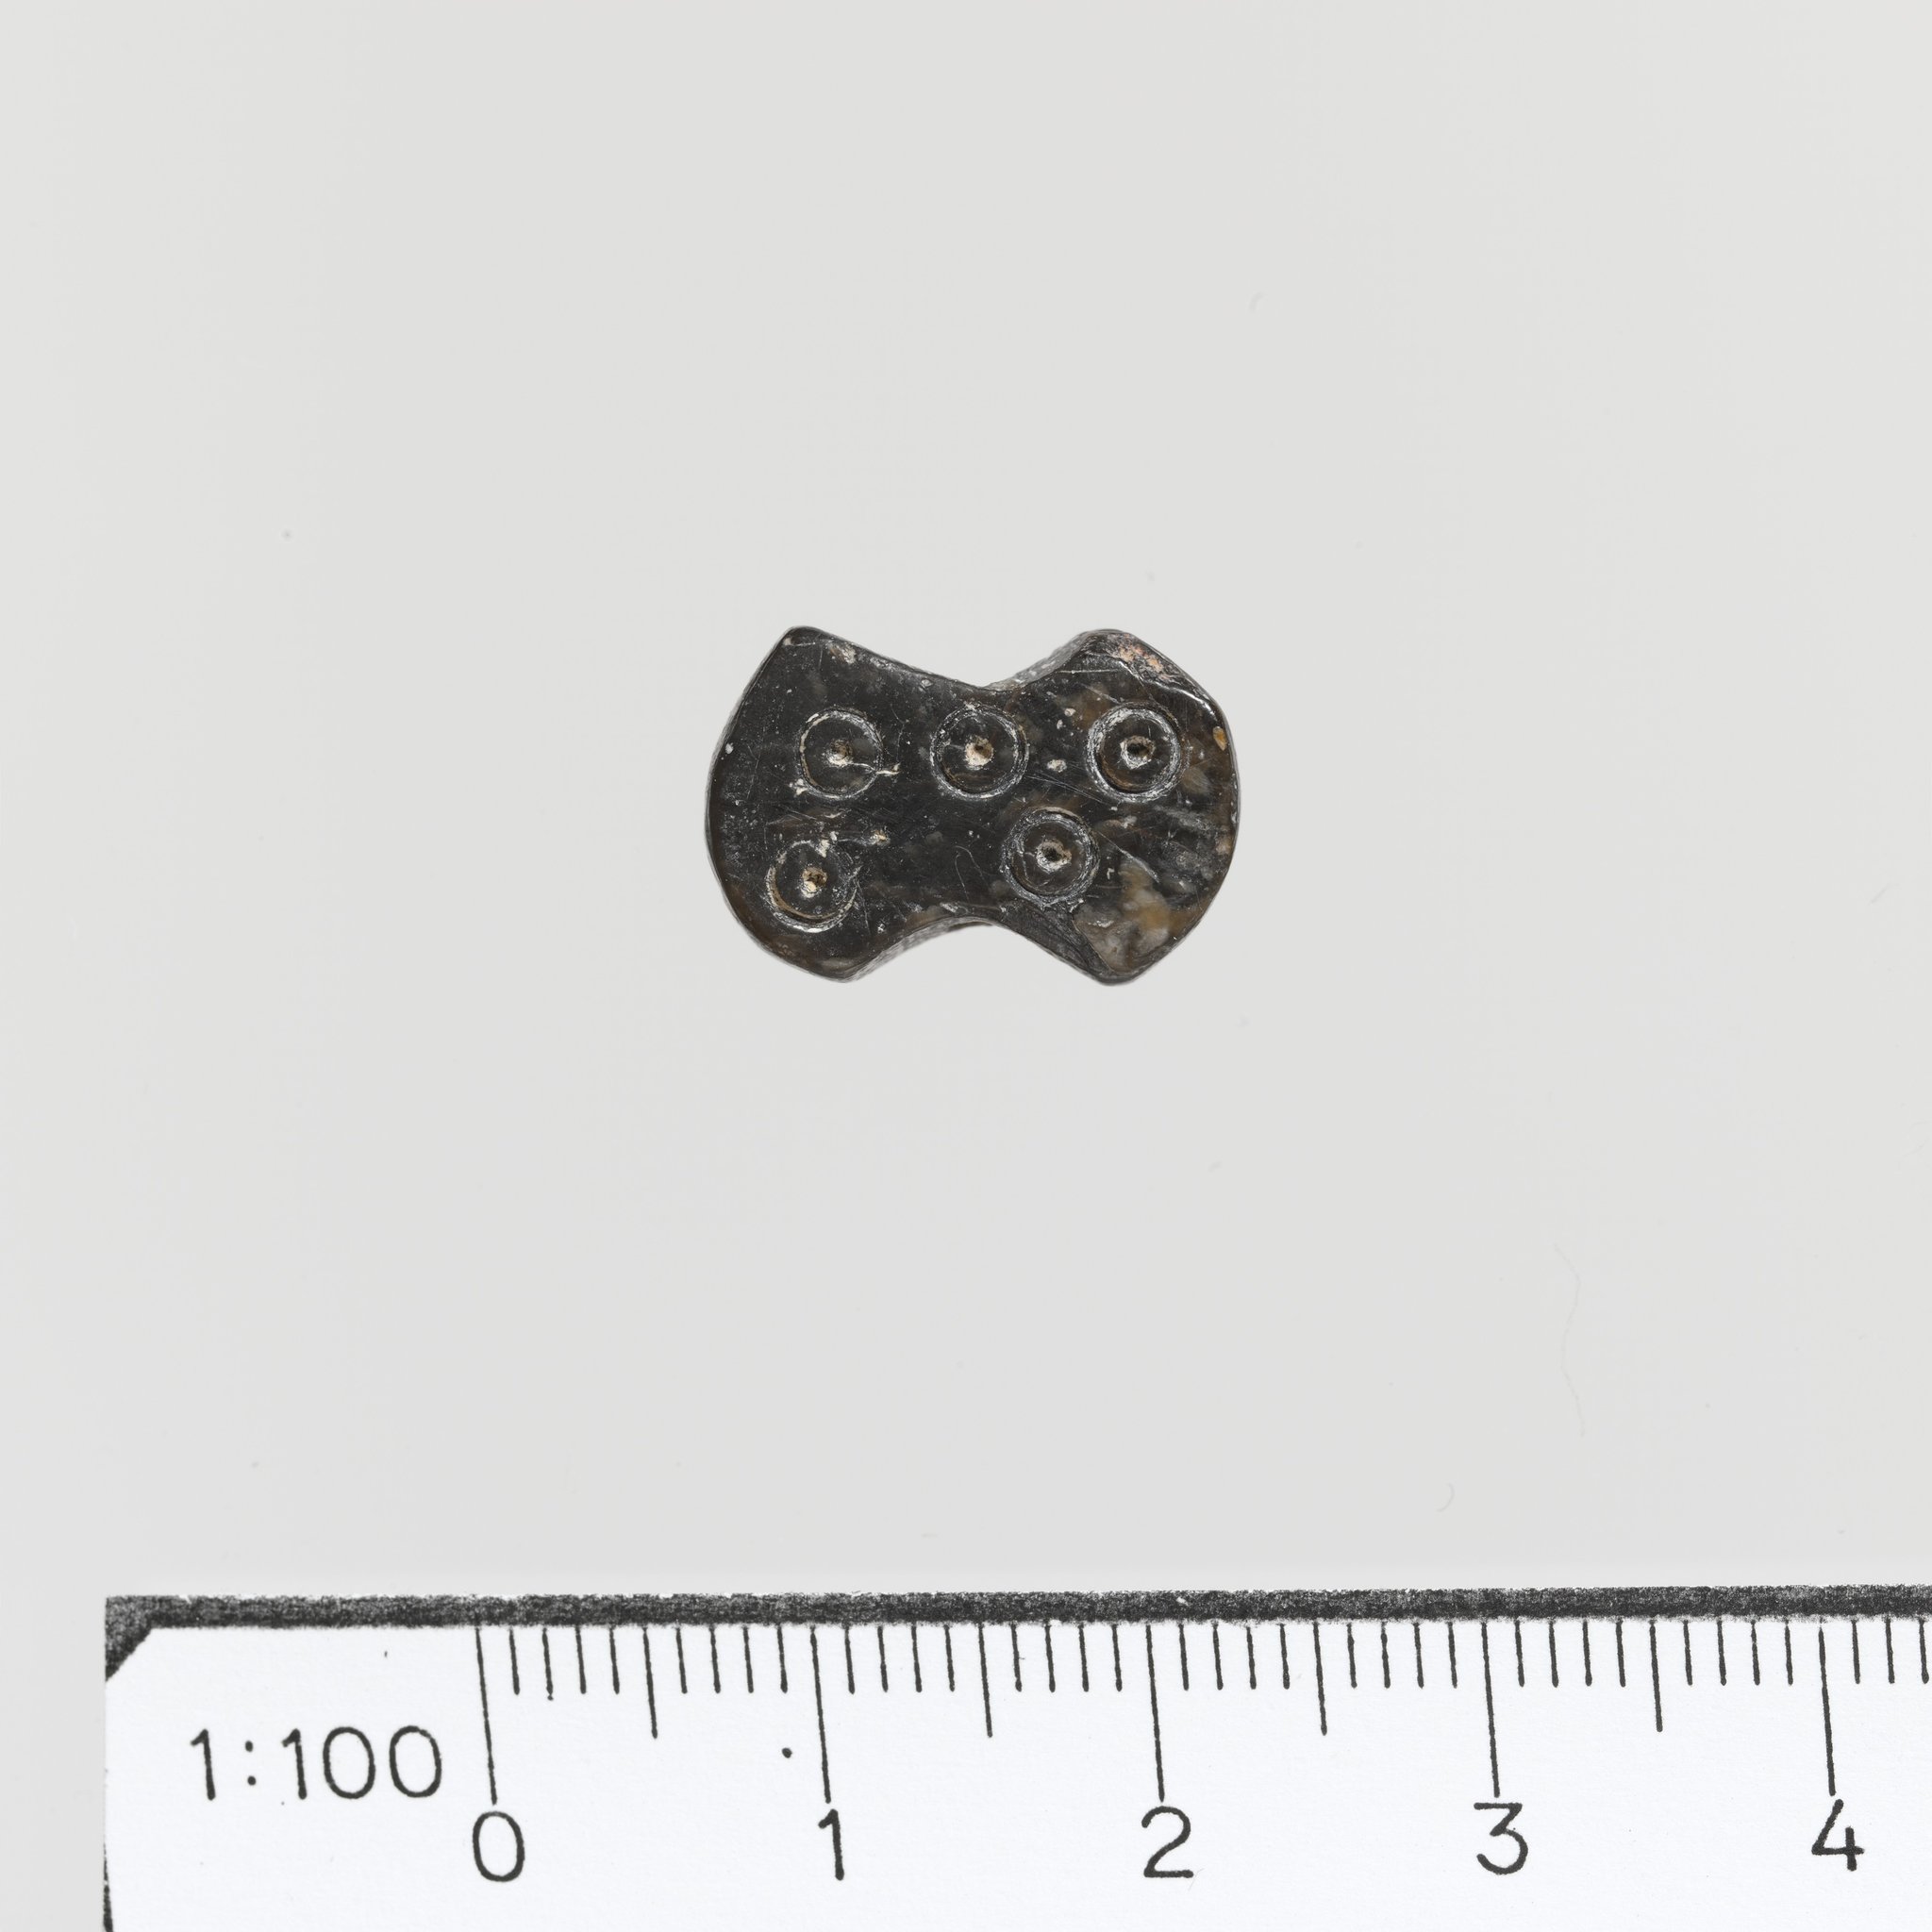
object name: seal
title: Steatite seal in the form of a double-axe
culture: minoan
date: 2200-1750 BCE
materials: stone